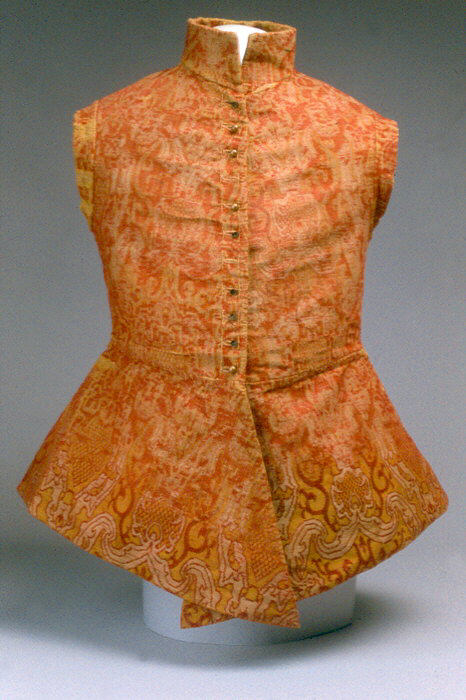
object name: jerkin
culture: european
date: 1601-1633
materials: silk